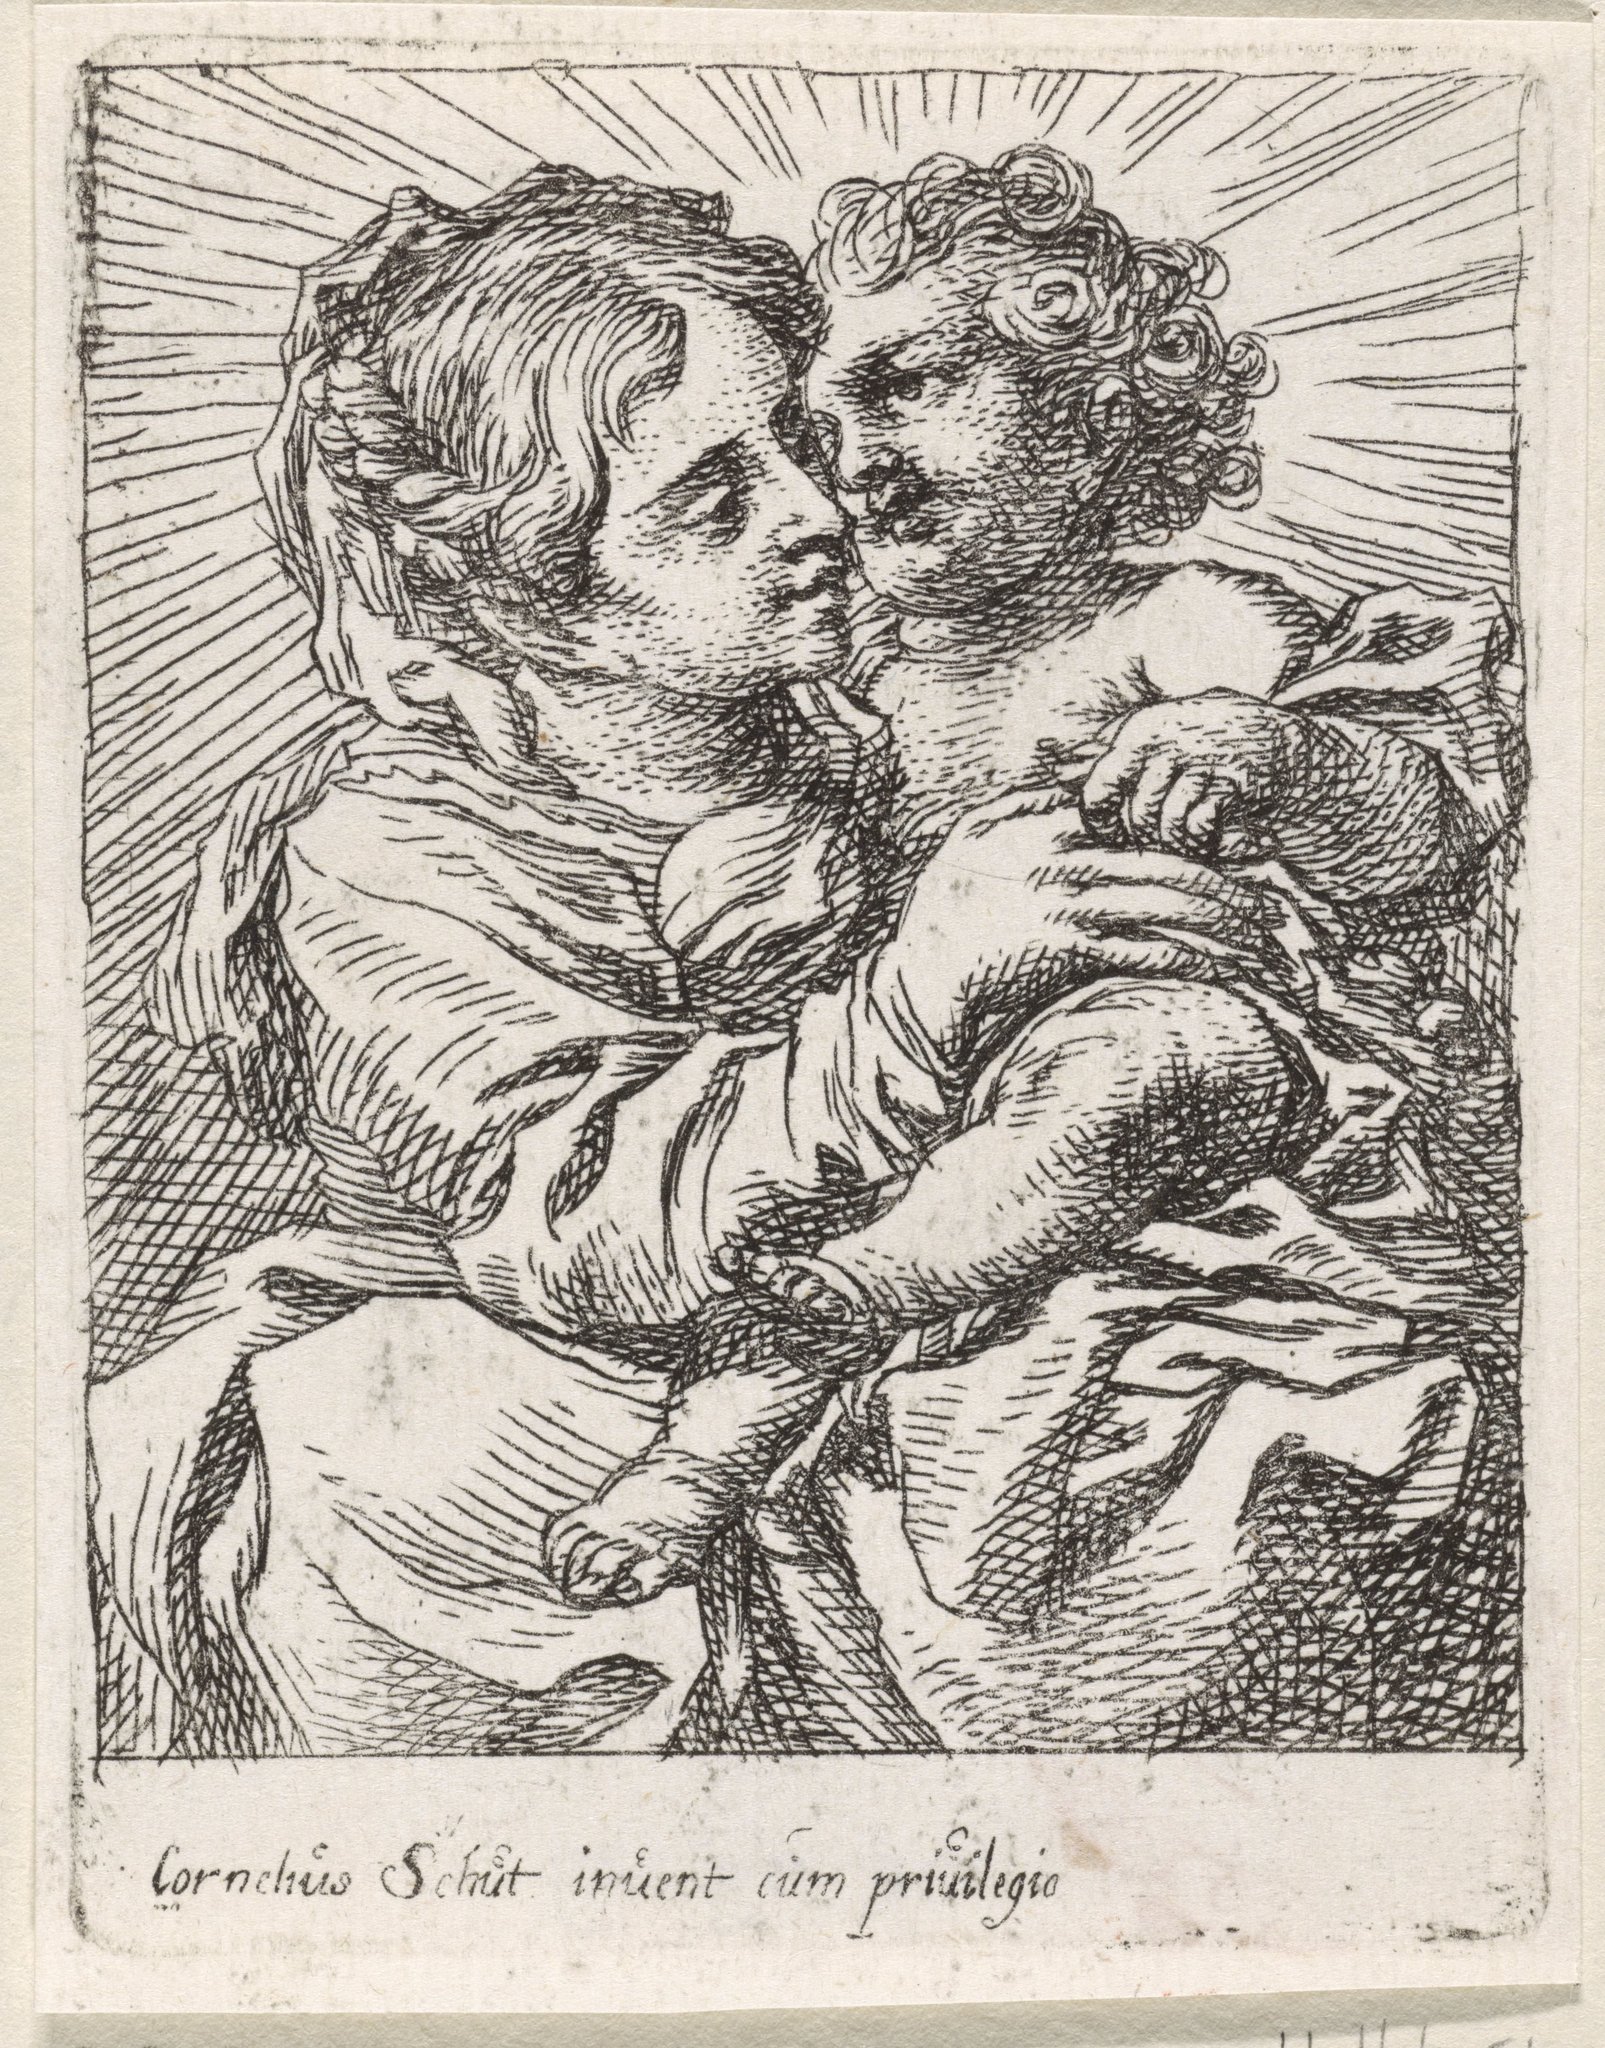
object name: print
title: Madonna met kind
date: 1618-1655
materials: paper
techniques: etching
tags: madonna: mary sitting or enthroned, the christ-child in her lap (or in front of her bosom) (mary sometimes represented half-length)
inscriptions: collector's mark: Lugt 240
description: Maria draagt het Christuskind op de arm. Hij houdt haar wijsvinger vast.